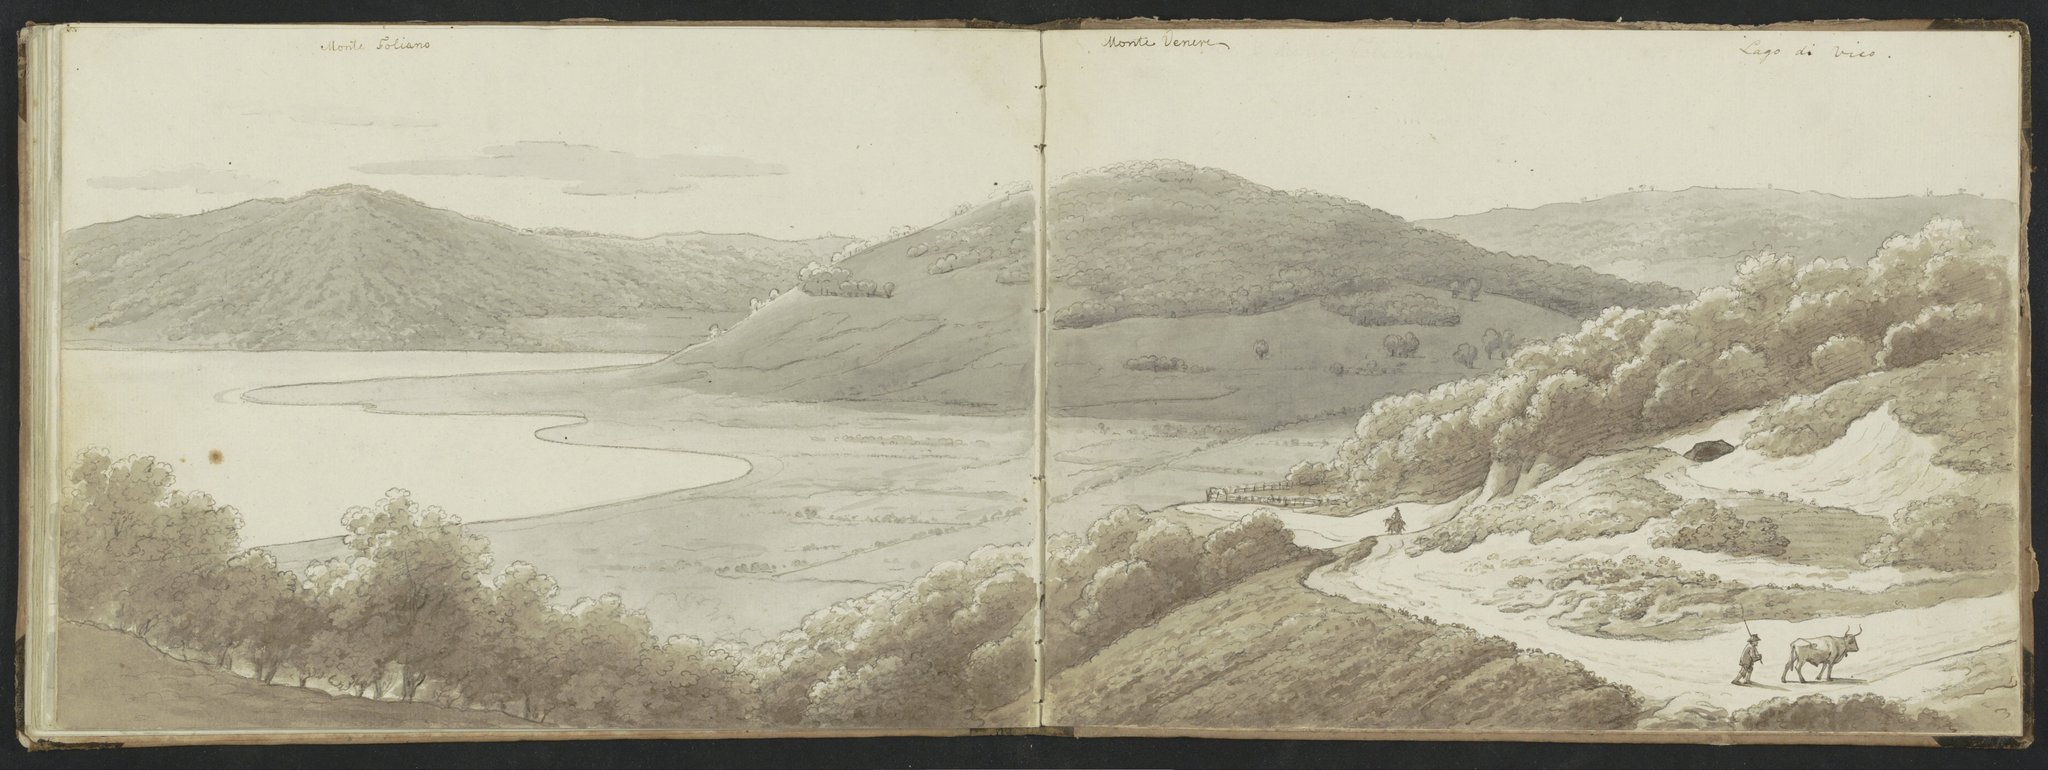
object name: sketchbook leaf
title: Vicomeer met zicht op Monte Fogliano en Monte Venere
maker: abraham teerlink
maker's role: draughtsman, painter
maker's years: 1776-1857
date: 1808-1857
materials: ink, paper, pencil, watercolor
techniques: brush, pen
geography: vicomeer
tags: lake, mountains (+ landscape with figures, staffage)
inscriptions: annotation: ‘Monte Foliano Monte Venere Lago di Vico.’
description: Op de voorgrond een man met os en een ruiter op een pad. Blad 26 verso en 27 recto uit een schetsboek met 28 bladen.